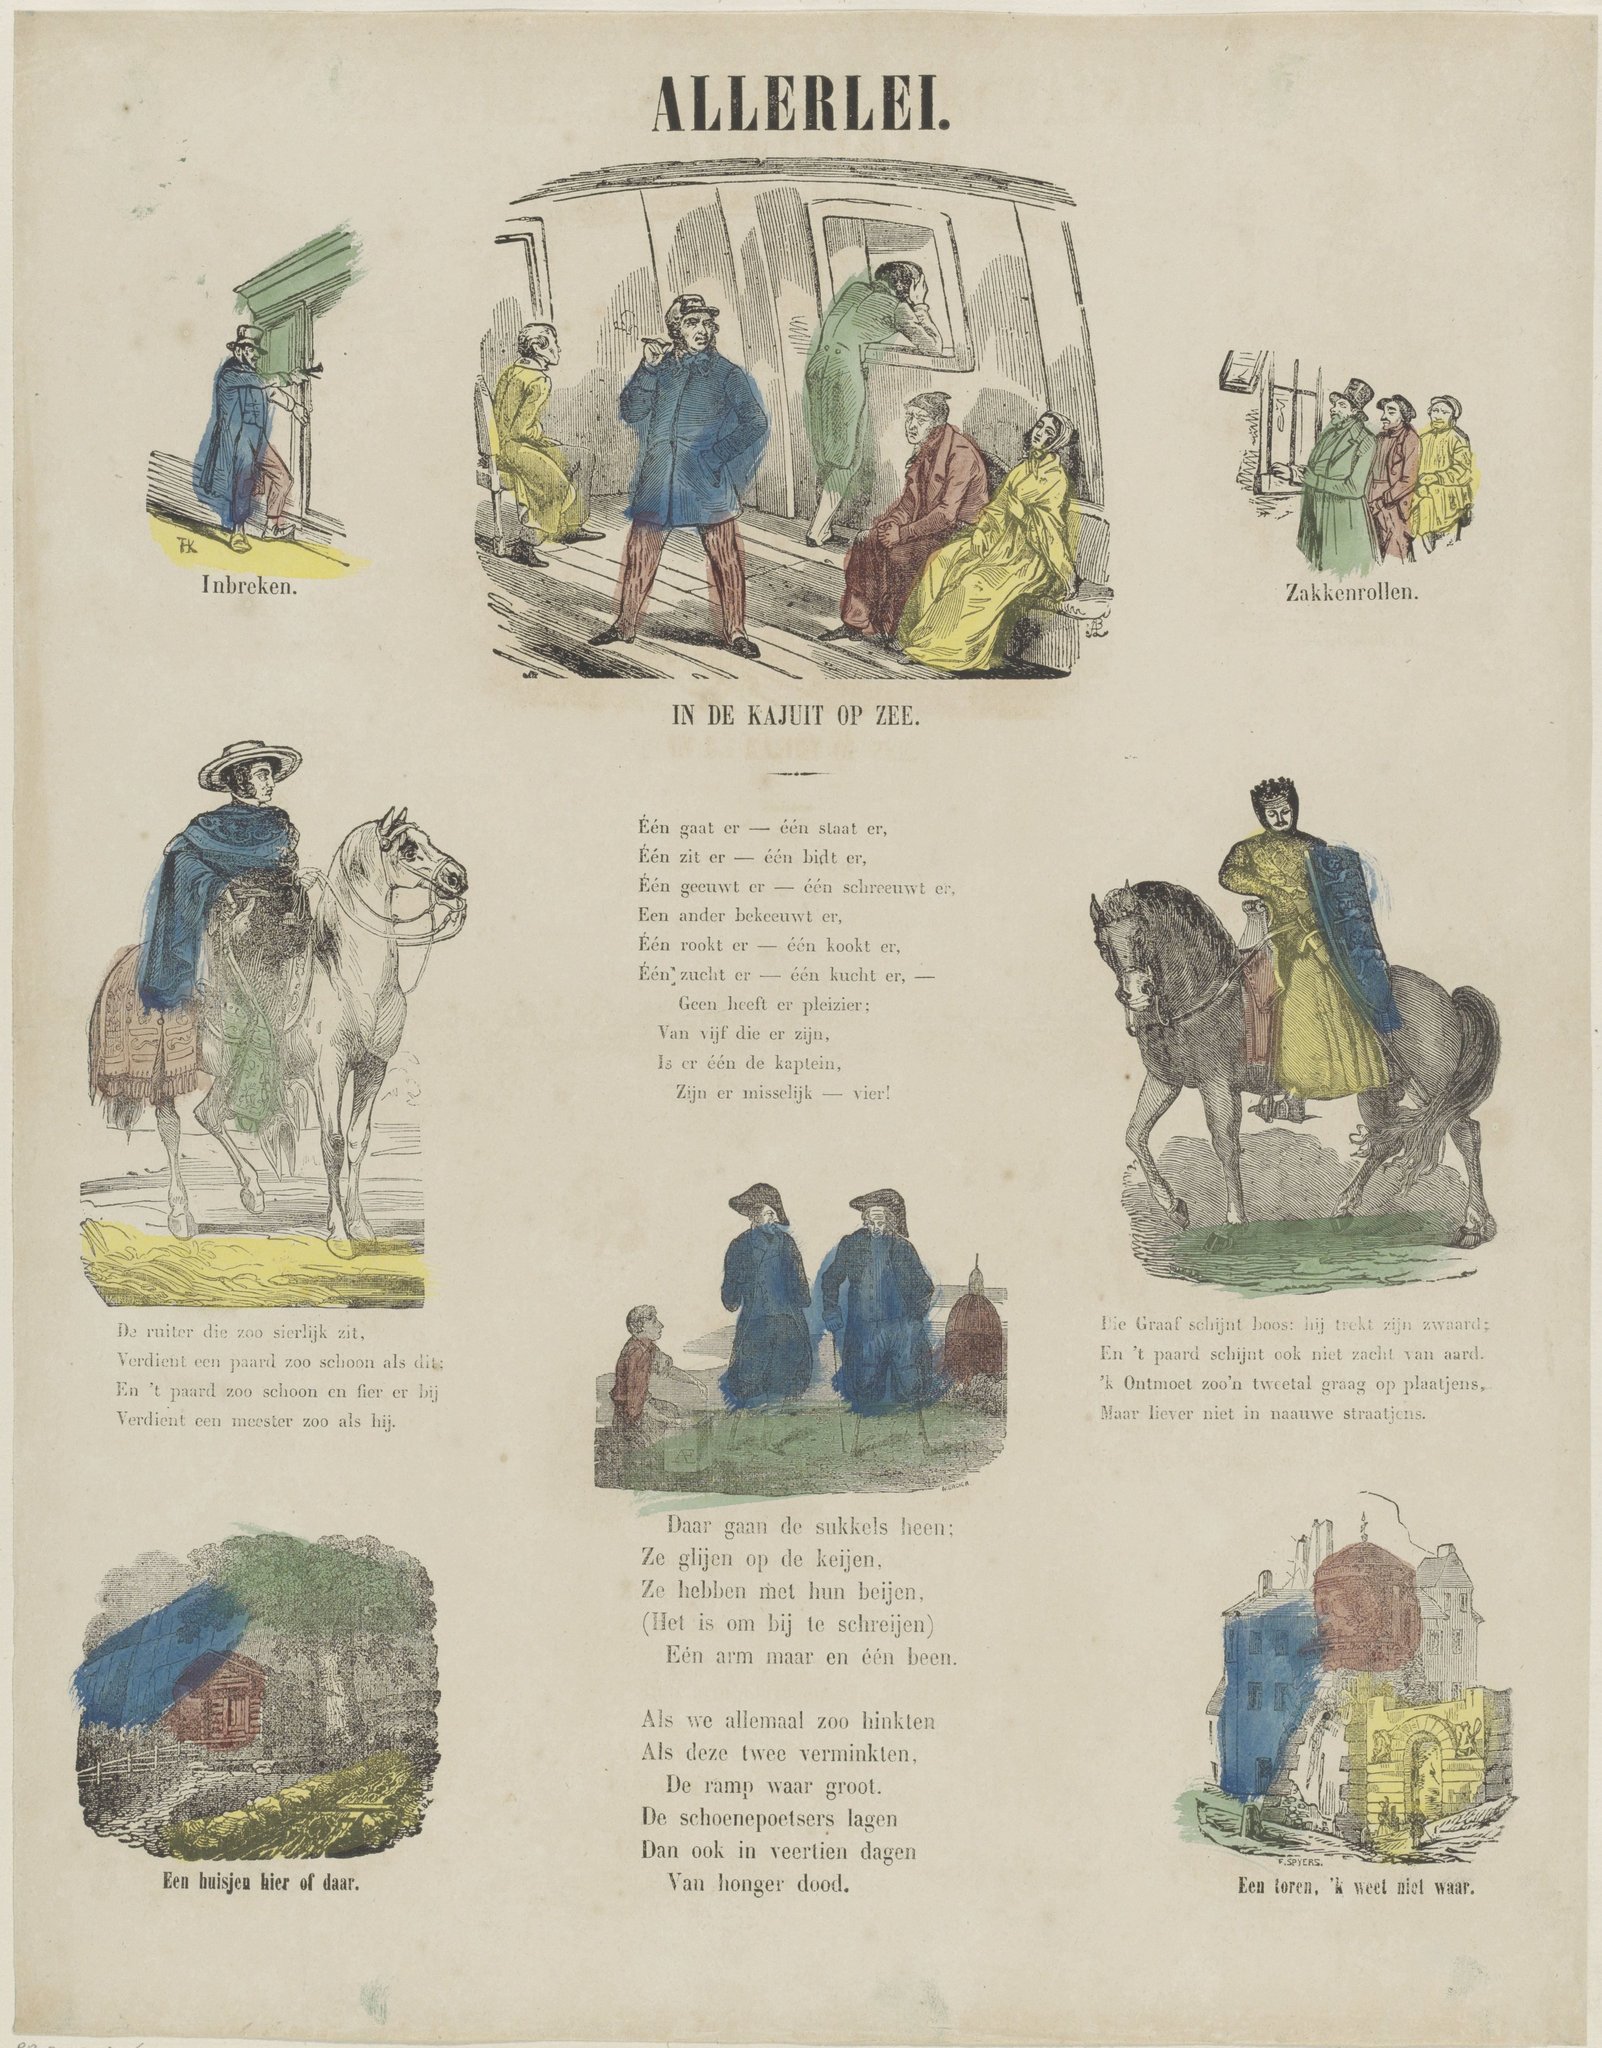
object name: popular print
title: Allerlei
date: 1861-1929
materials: paper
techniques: colour, letterpress printing, engraving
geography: europe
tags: tower, clock tower ~ monumental adornment, human types, burglar, housebreaker, characters (human types)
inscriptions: collector's mark: Lugt 2760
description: Blad met 8 voorstellingen van verschillende aard, zoals voorstellingen van een inbreker, van een graaf te paard en van een toren. Onder elke afbeelding een onderschrift in boekdruk.